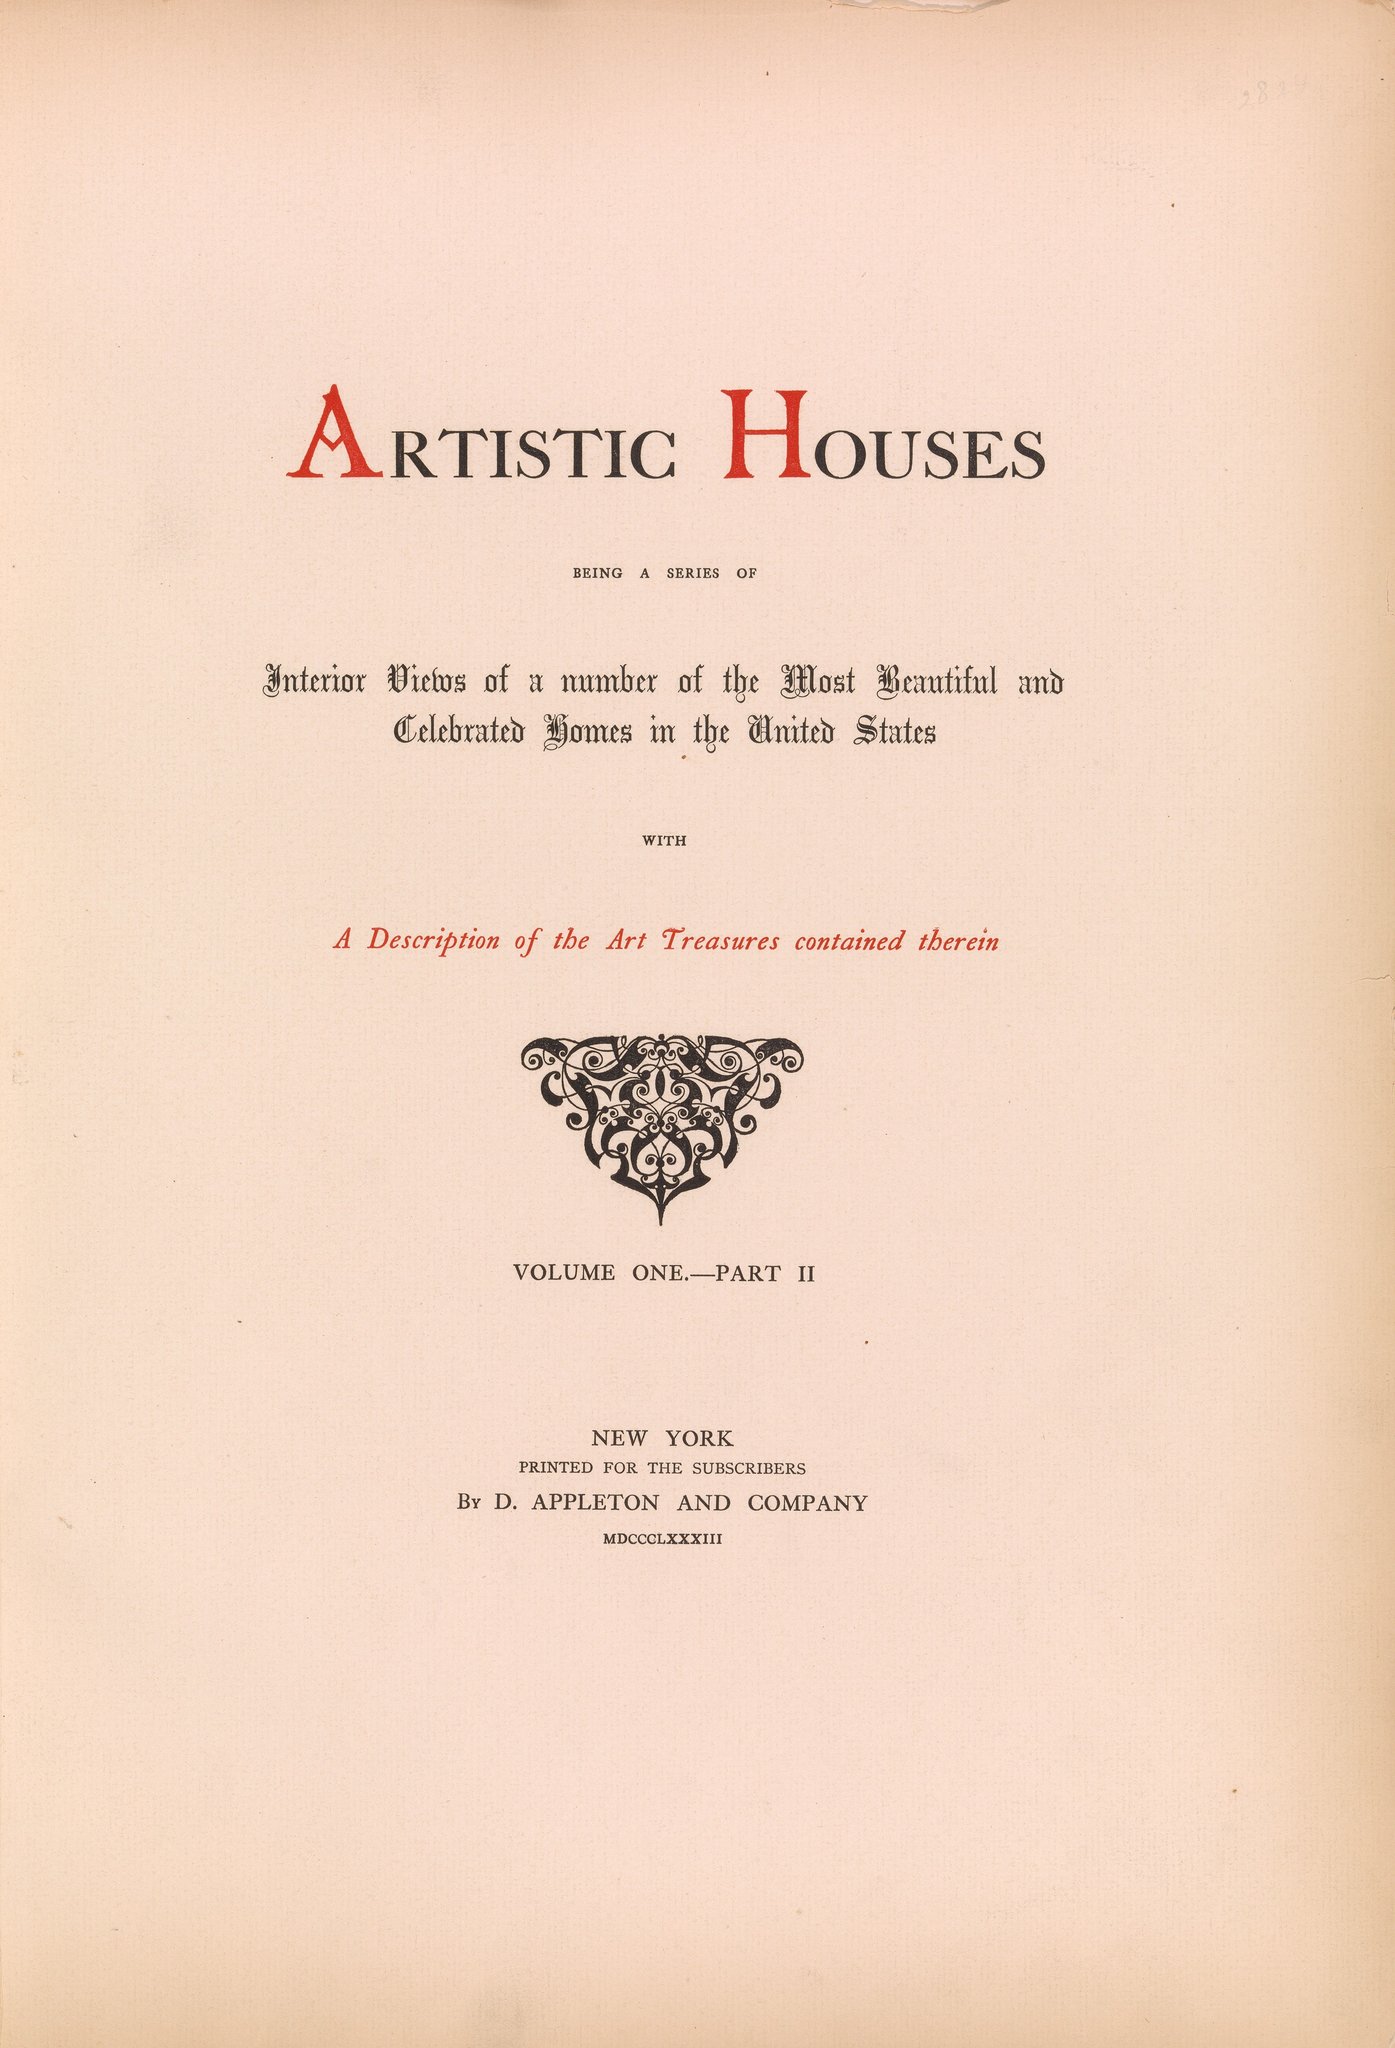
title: Artistic houses : being a series of interior views of a number of the most beautiful and celebrated homes in the United States : with a description of the art treasures contained therein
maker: d. appleton & co.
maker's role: publisher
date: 1883-1884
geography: new york